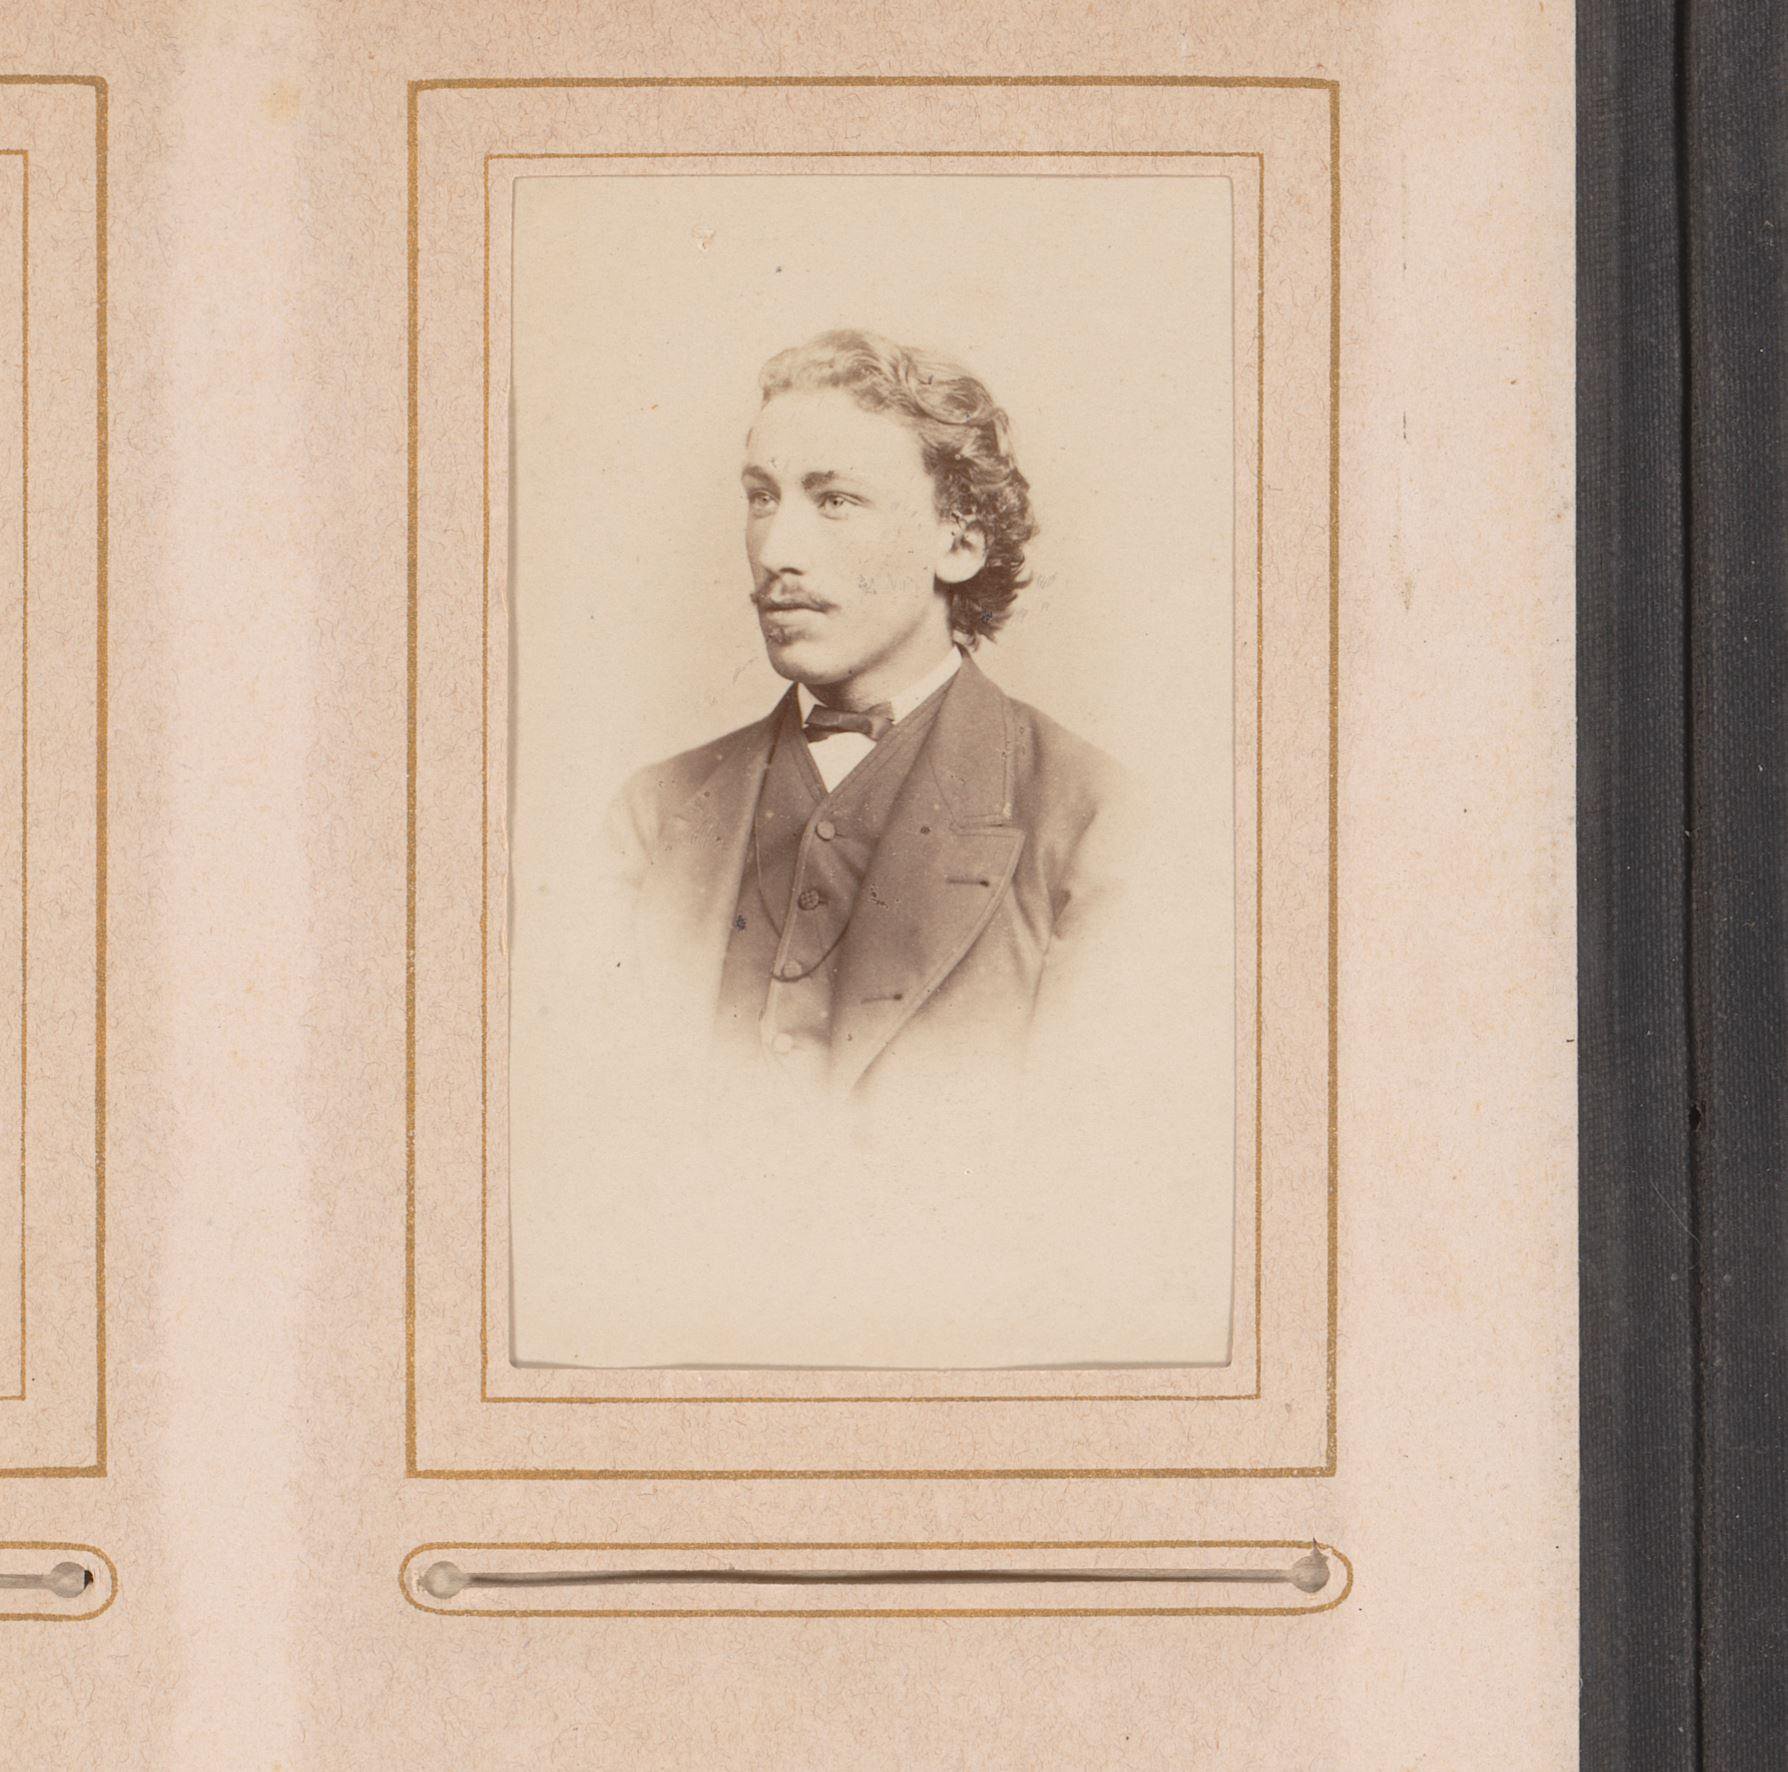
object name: photograph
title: Portret van een man met snor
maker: george lodewijk mulder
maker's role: fotograaf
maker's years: 1841-1920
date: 1859-1898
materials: cardboard, photographic support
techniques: albumen print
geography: utrecht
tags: moustache, historical persons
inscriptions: inscription: ‘Photogr. Atelier van/ G.L. Mulder/ van Wijckskade H.326/ Utrecht’